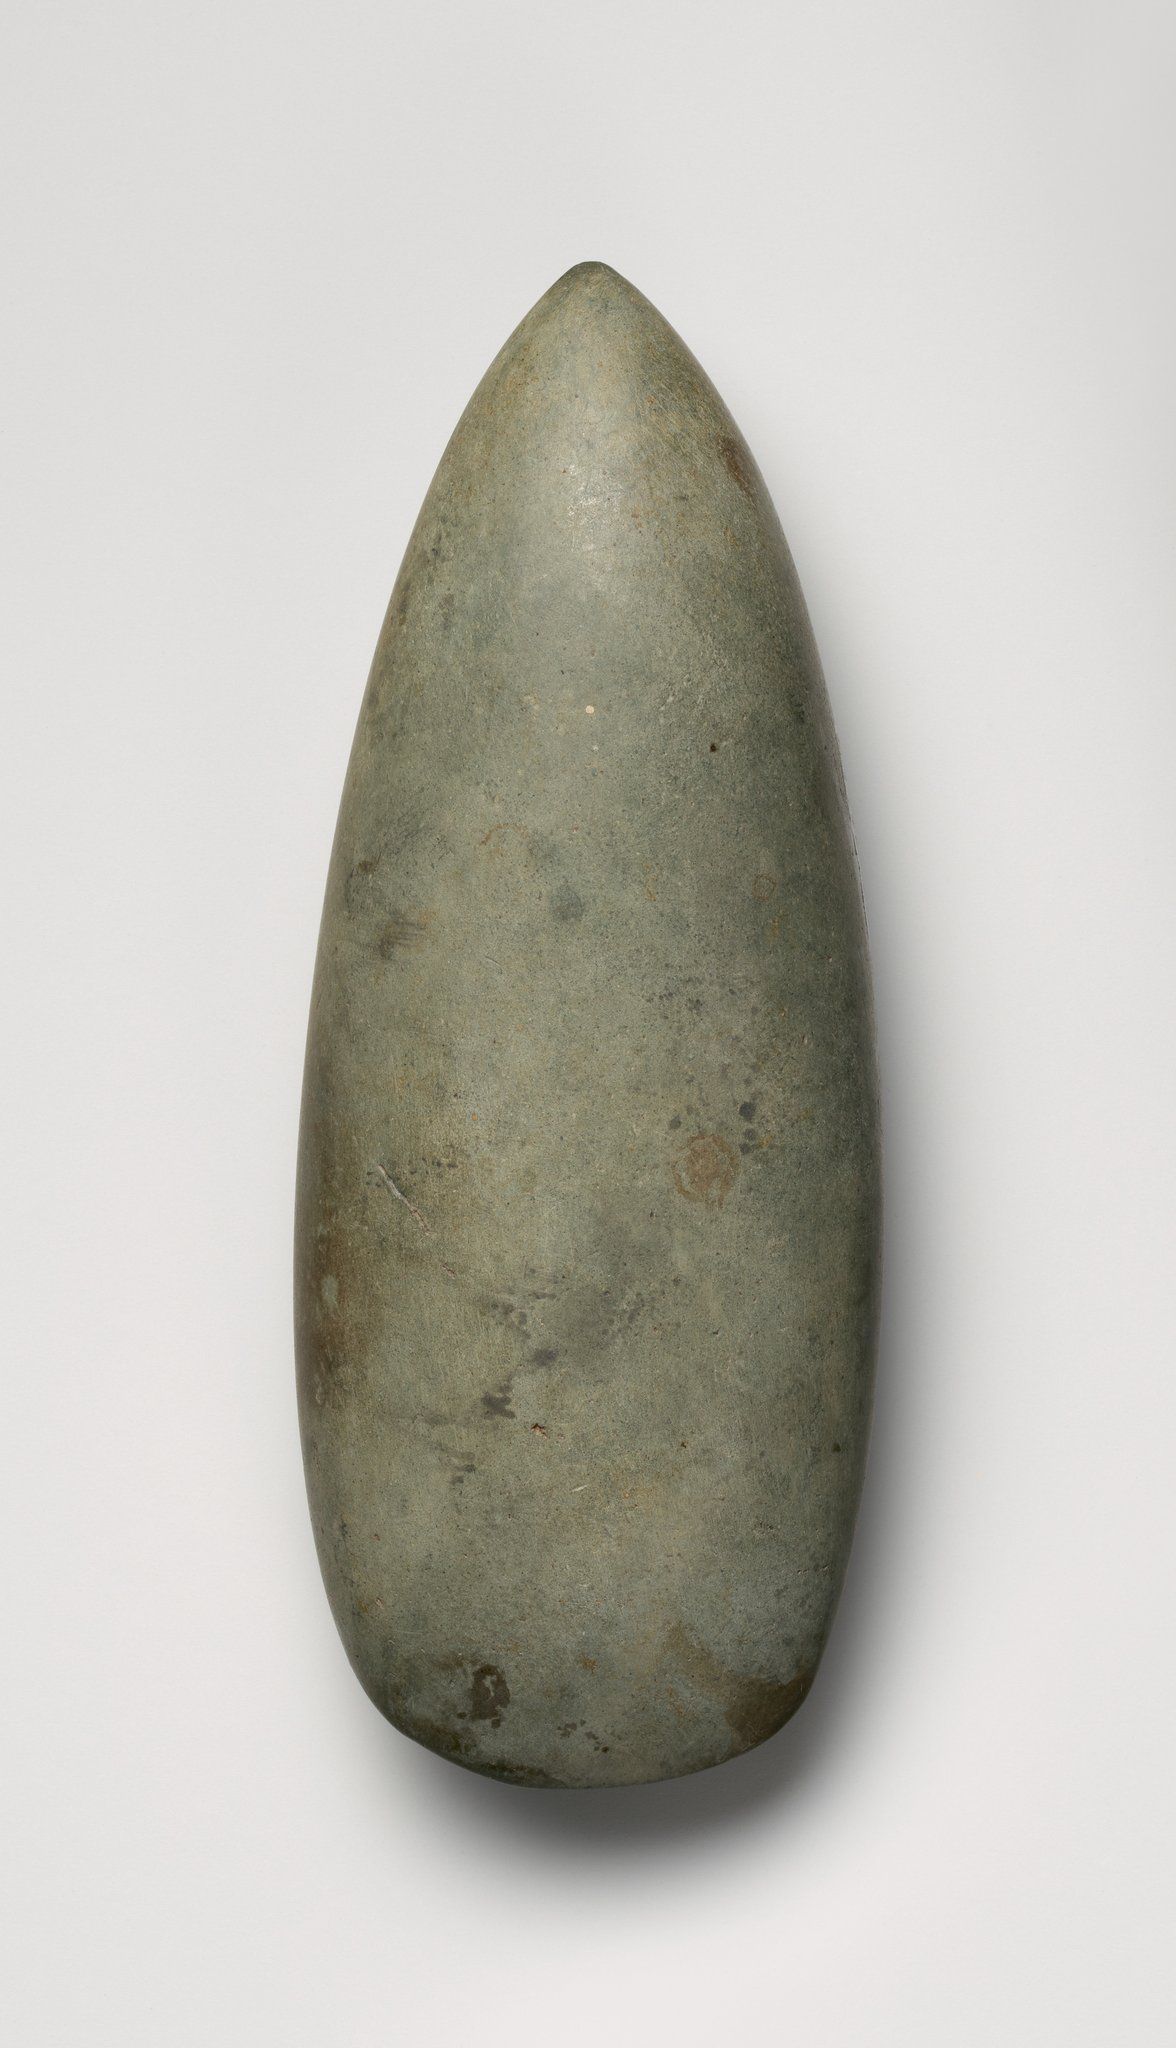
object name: celt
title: Stone Celt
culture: taíno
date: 1501-1600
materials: stone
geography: dominican republic